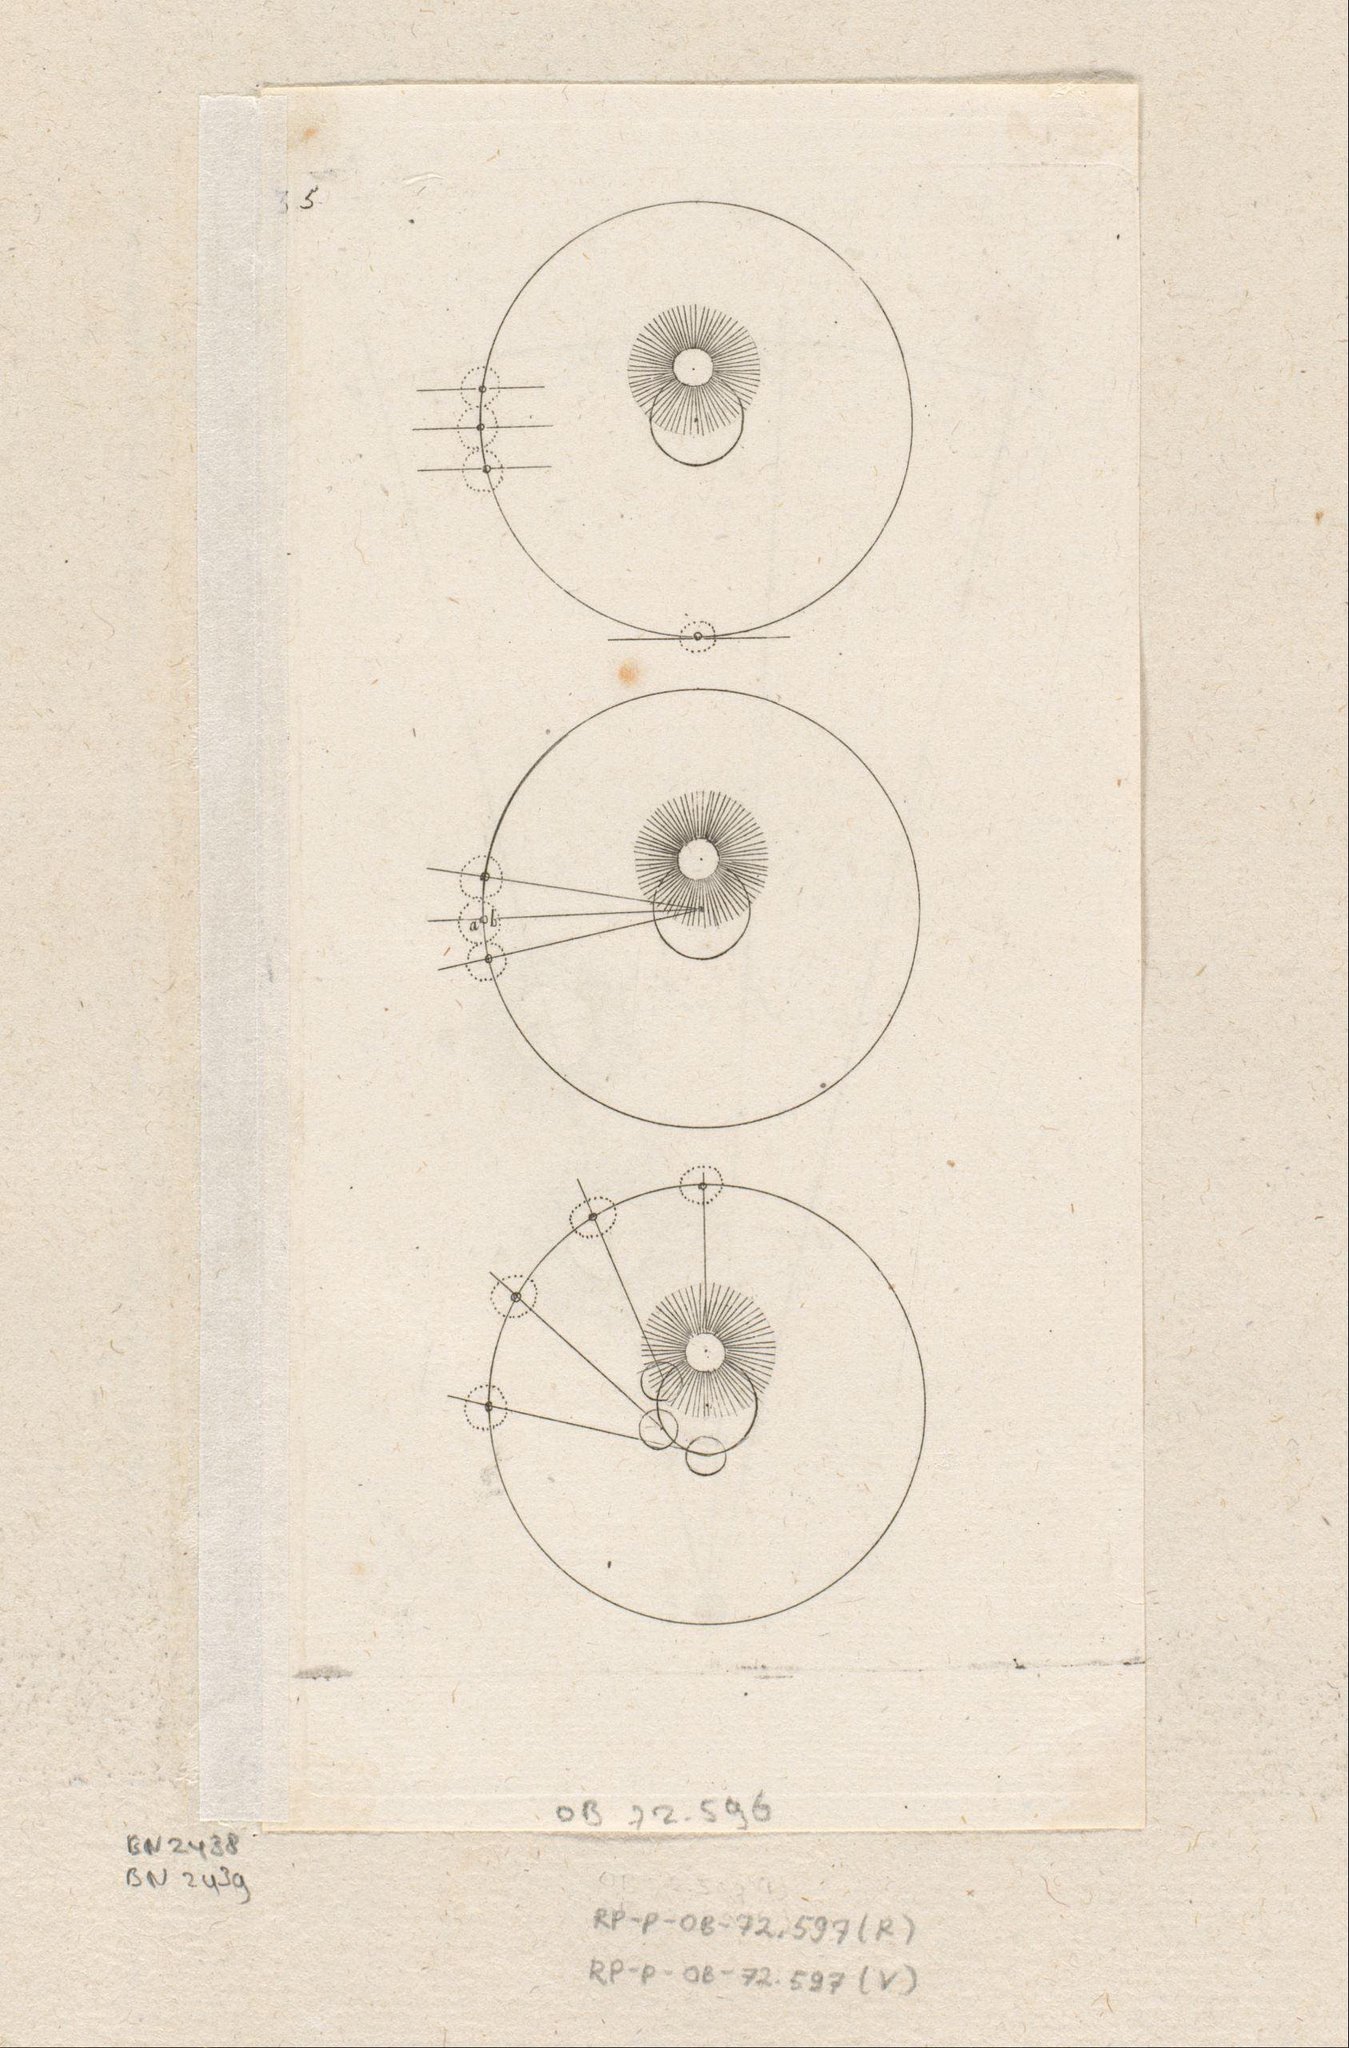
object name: print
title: Revolutie van de Aarde en de Zon rond het centrum van de wereld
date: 1706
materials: paper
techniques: etching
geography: france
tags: earth, world as celestial body, sun as celestial body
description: Prent uit: Leclerc, Sébastien. Nouveau systeme du monde conforme à l'Ecriture sainte. Où les phénomènes sont expliquez sans excentricité de mouvement (...). Paris: Pierre Giffart, 1706.